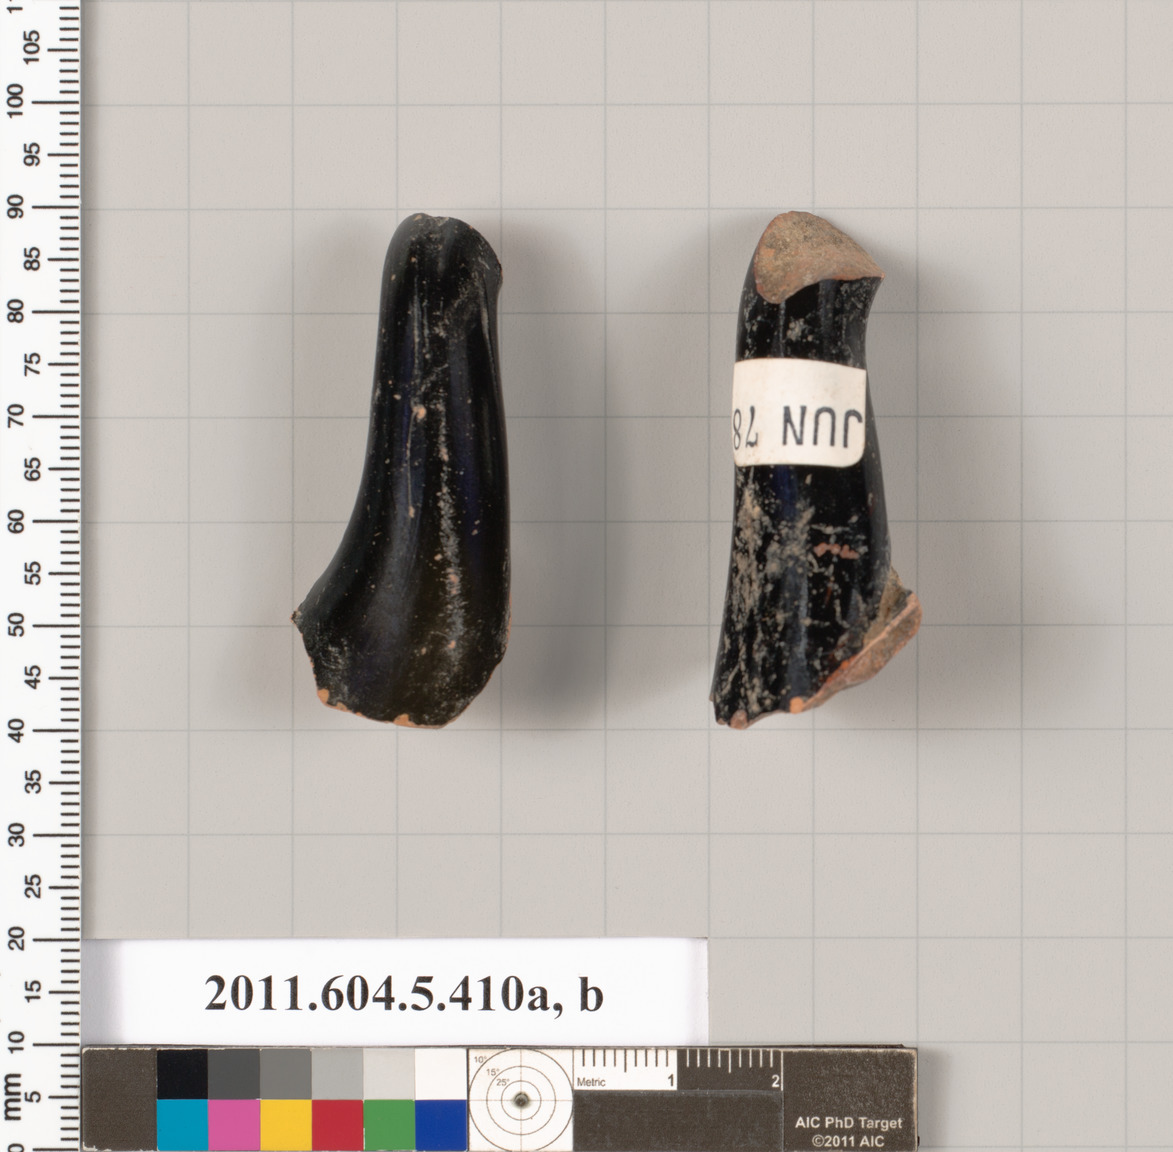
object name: kylix fragment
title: Terracotta fragments of kylikes (drinking cups)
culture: greek, attic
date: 600-401 BCE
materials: terracotta